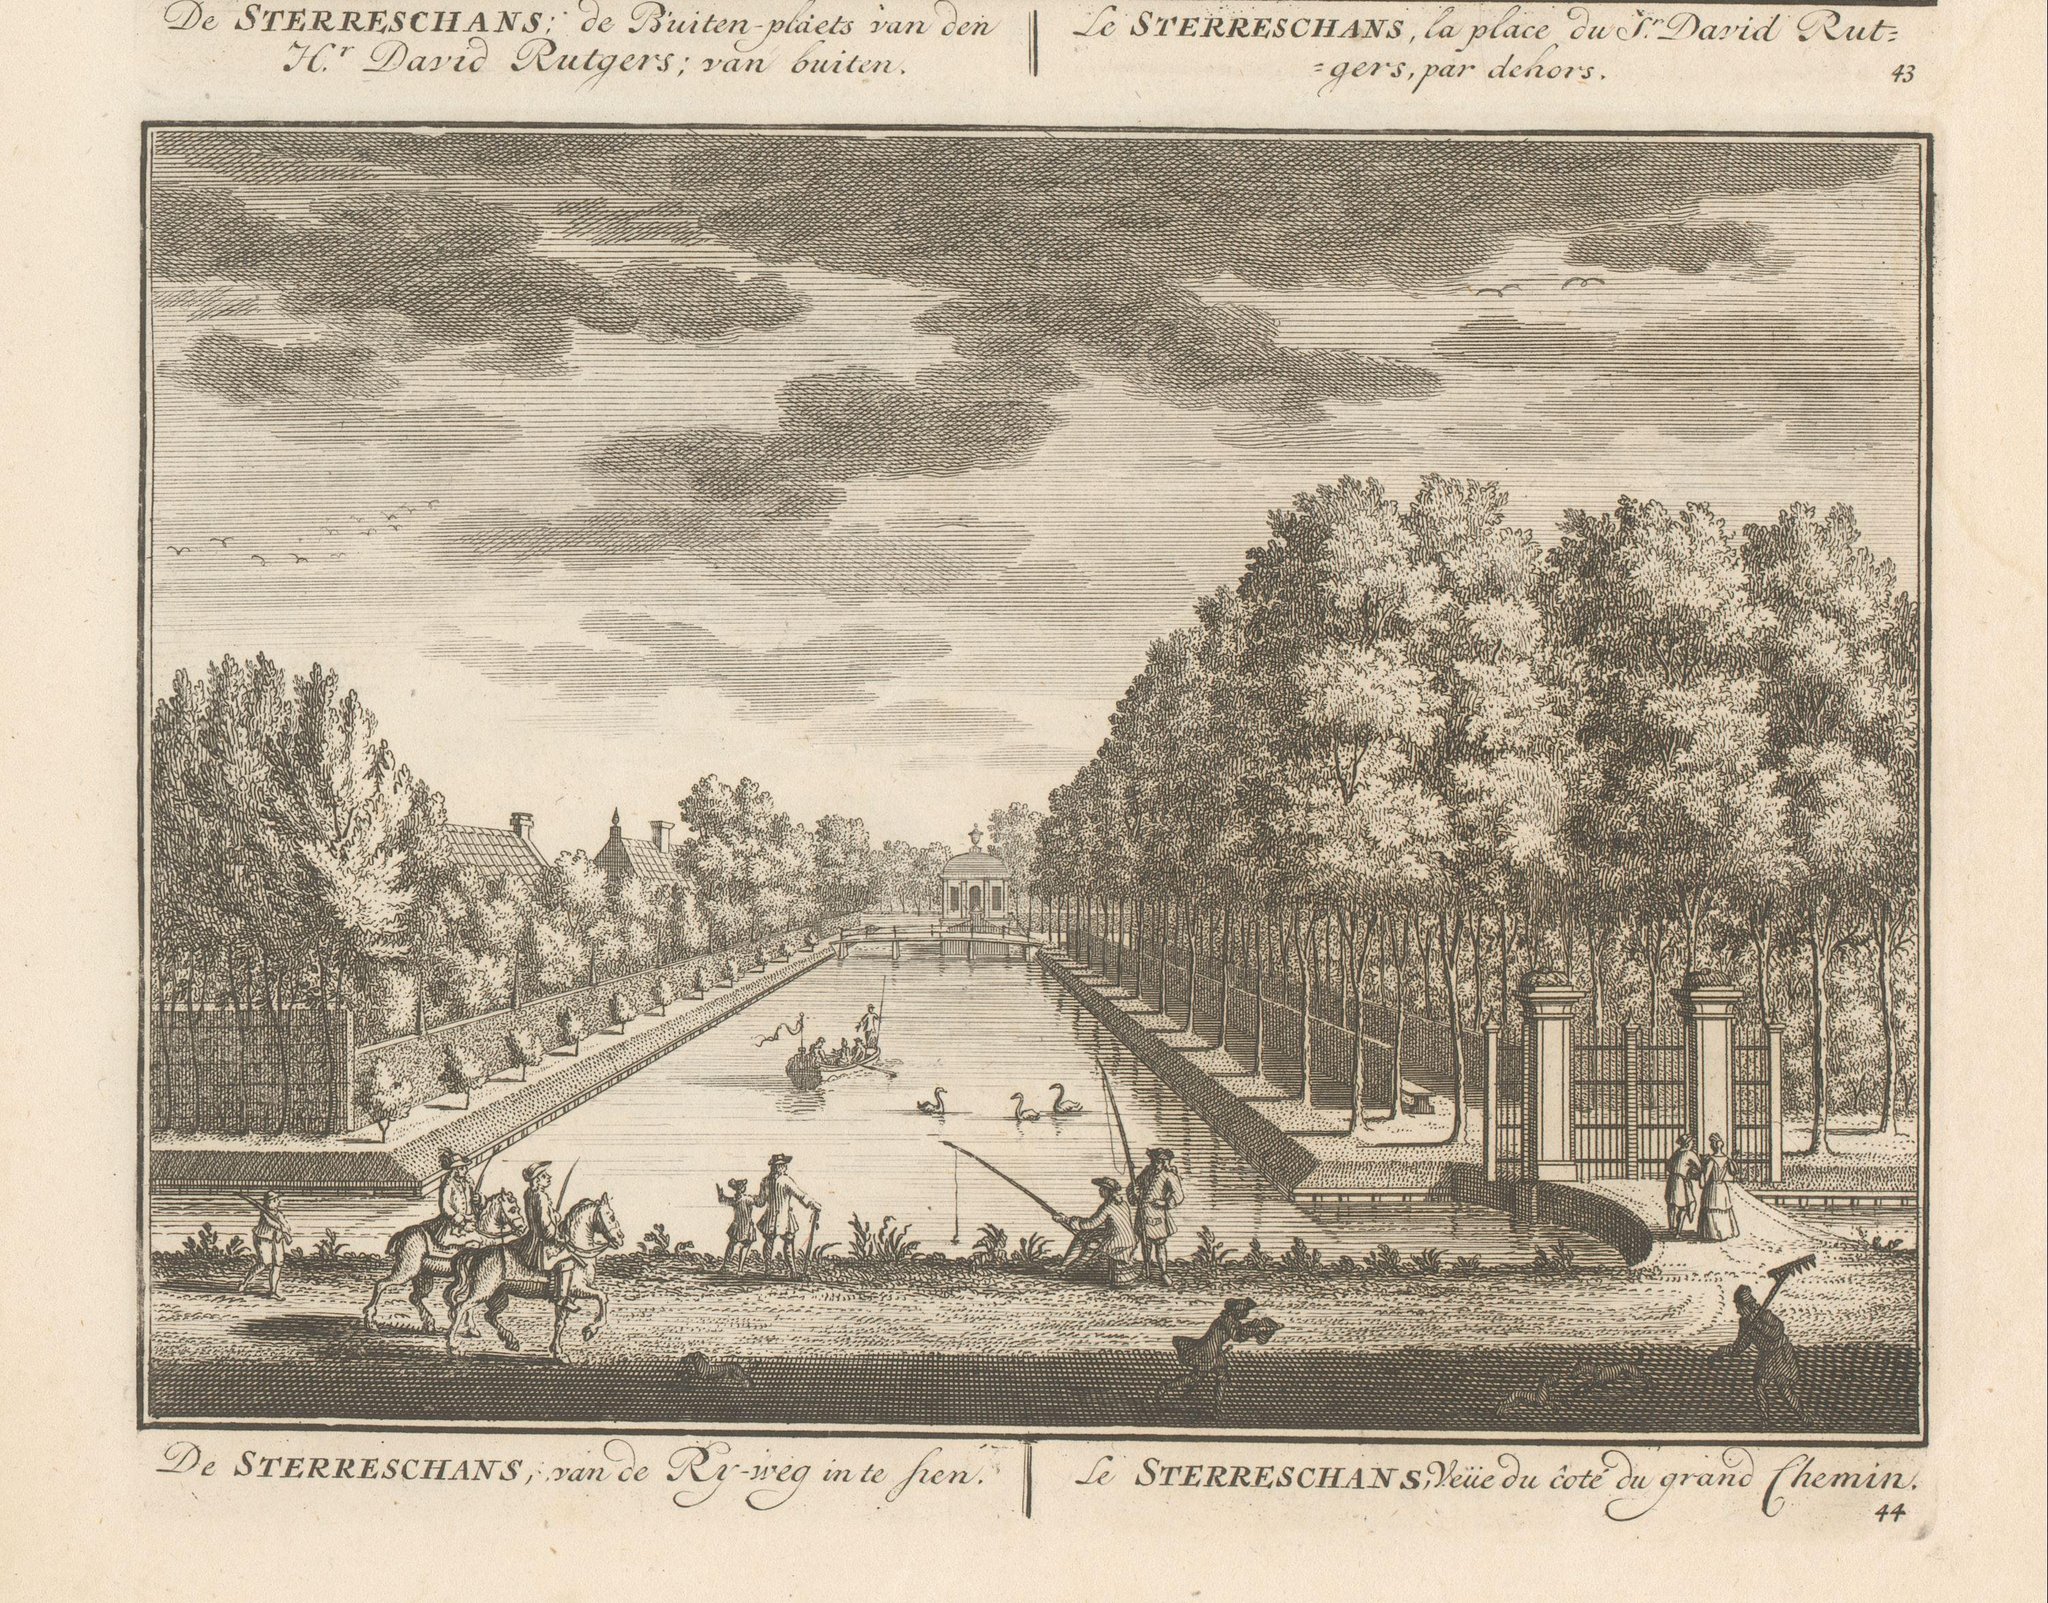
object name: album leaf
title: De Sterreschans, van de Ryweg in te sien / Le sterreschans, veiie du côté du grand Chemin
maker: daniël stopendaal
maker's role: print maker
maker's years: 1672-1726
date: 1790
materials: paper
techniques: engraving, etching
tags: river (+ landscape with figures, staffage), country-house, vecht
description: Prent gebruikt in: Leth, Andries de. De zegepraalende Vecht, vertoonende verscheidene gesichten van lustplaatsen, heeren huysen en dorpen, beginnende van Uitrecht en met Muyden besluytende (...). Amsterdam: Weduwe Nicolaus Visscher, 1719. Prent ook gebruikt in: Brouërius van Nidek, Matthaeus. De Vechtstroom, van Utrecht tot Muiden (...). Amsterdam: H. Gartman, W. Vermandel en J.W. Smit, 1790.